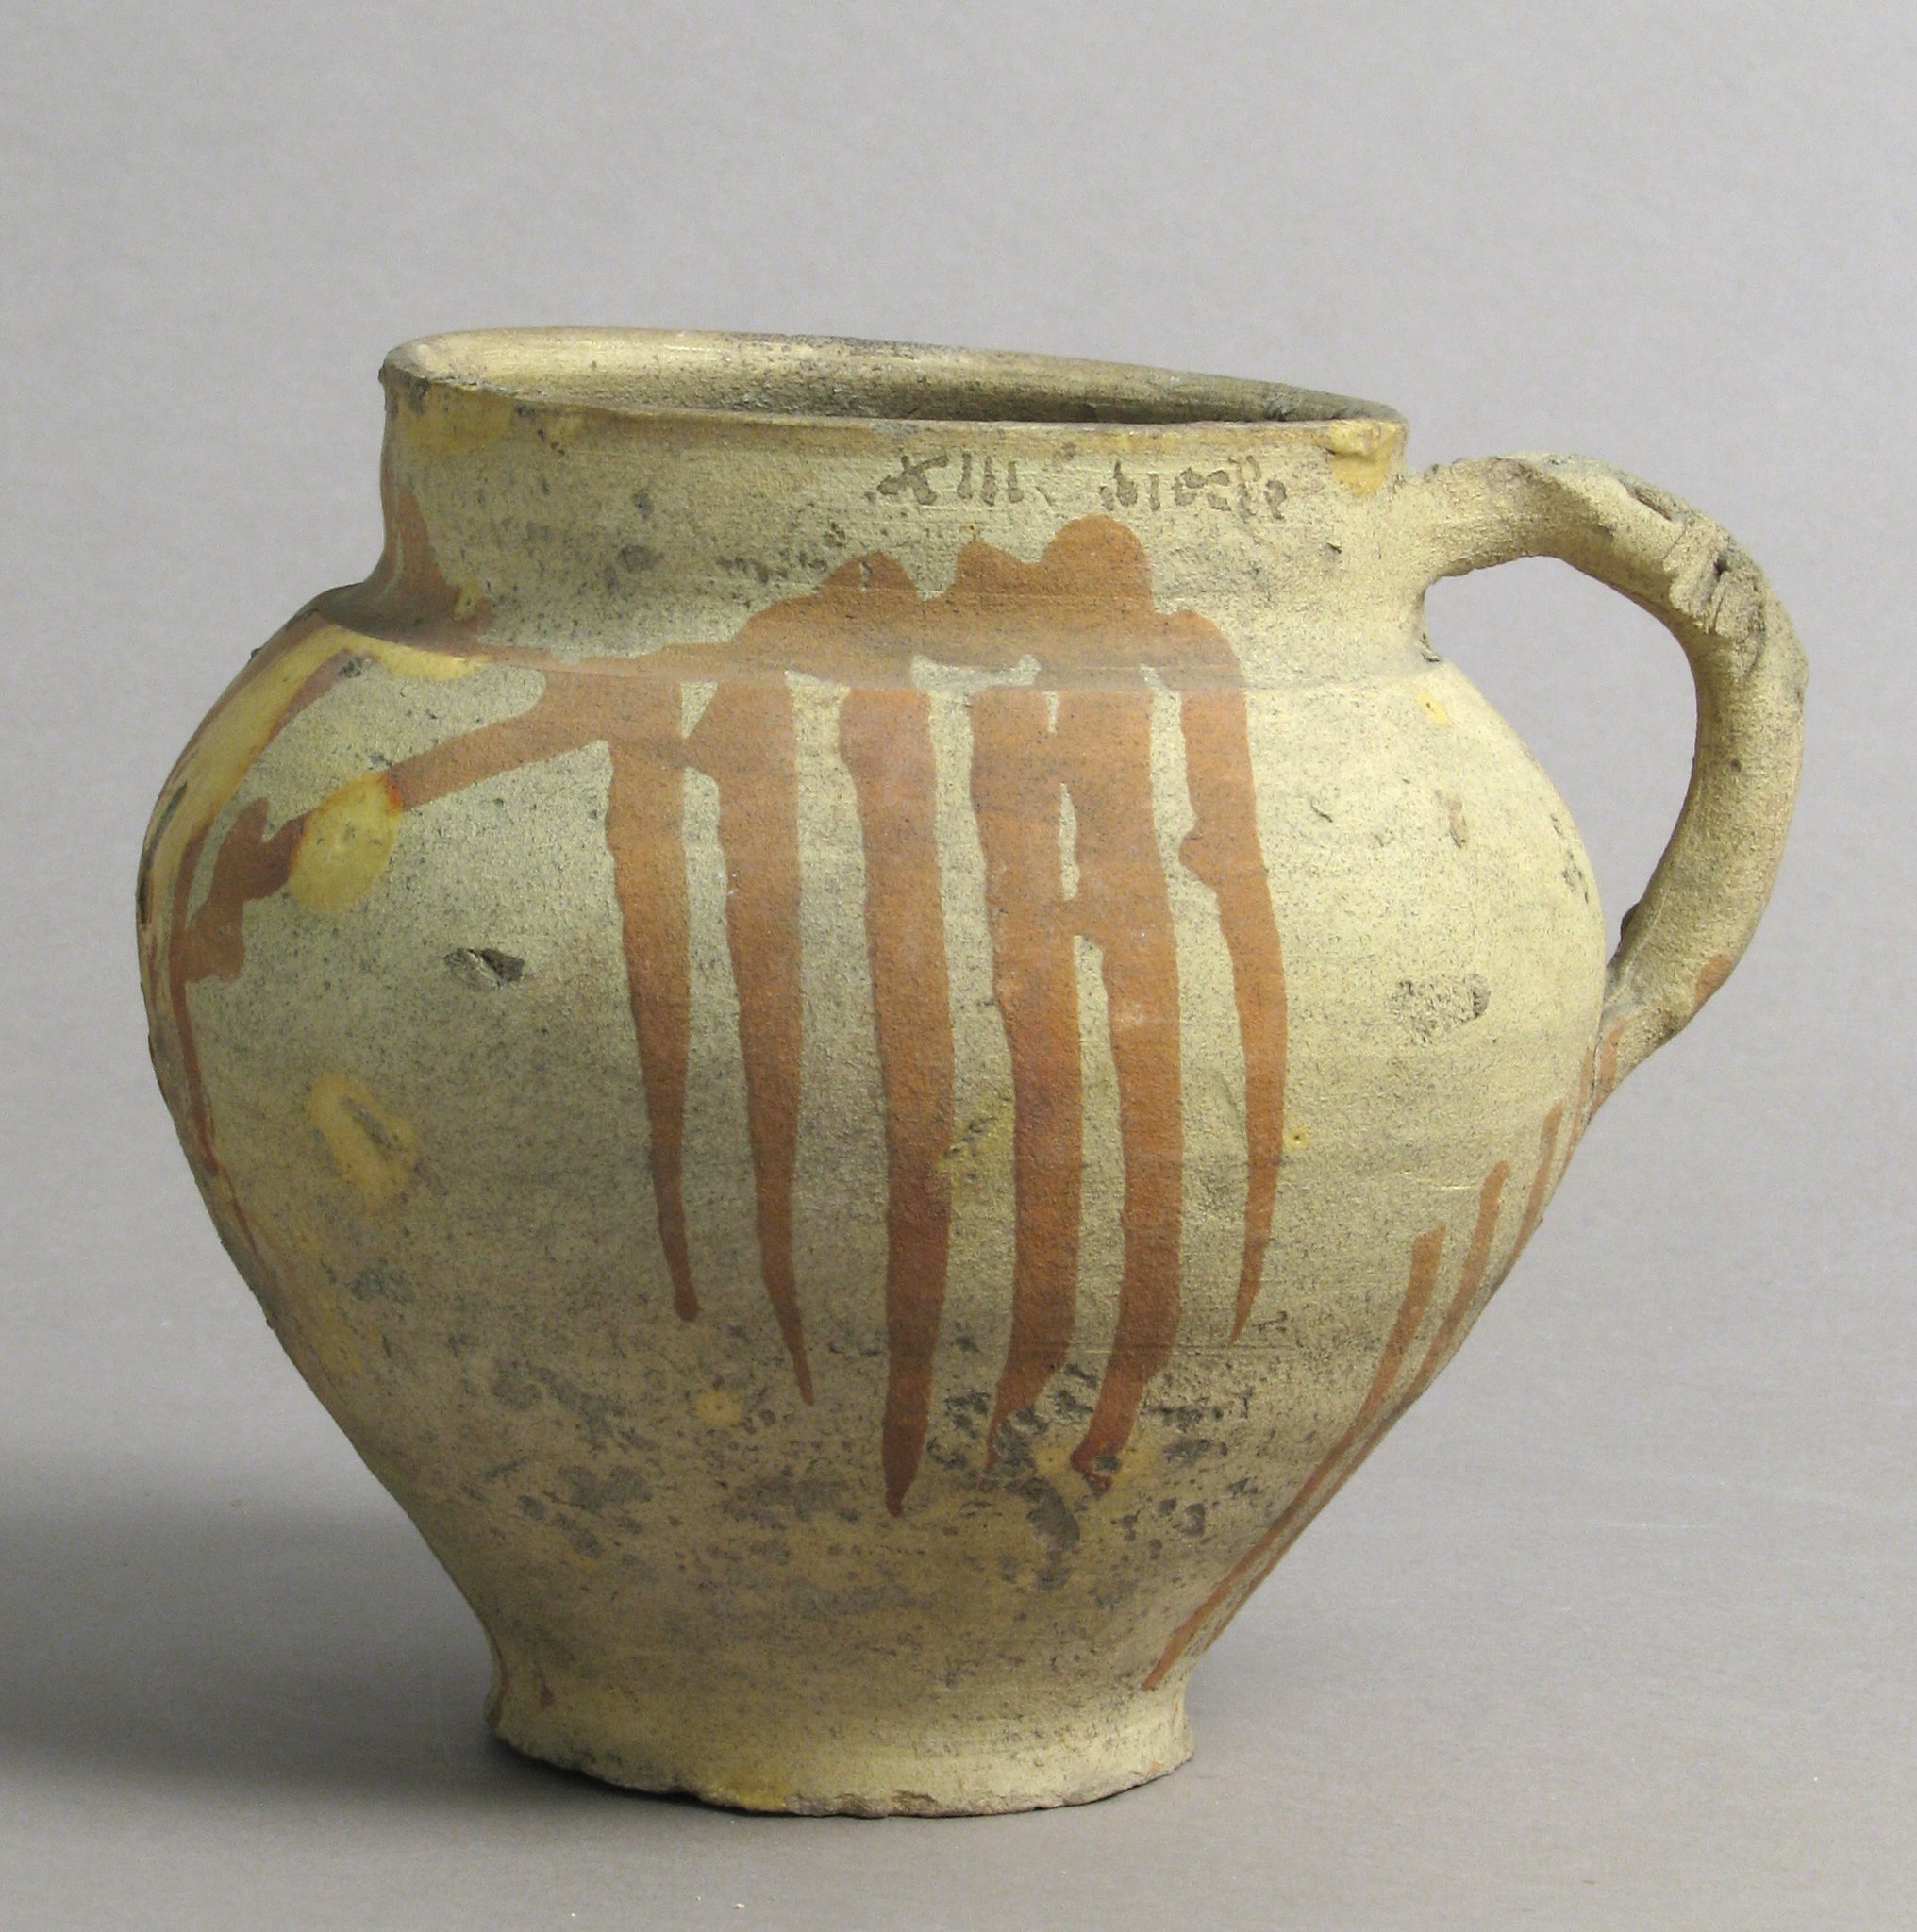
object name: jar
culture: french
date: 1200-1400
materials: earthenware, glaze